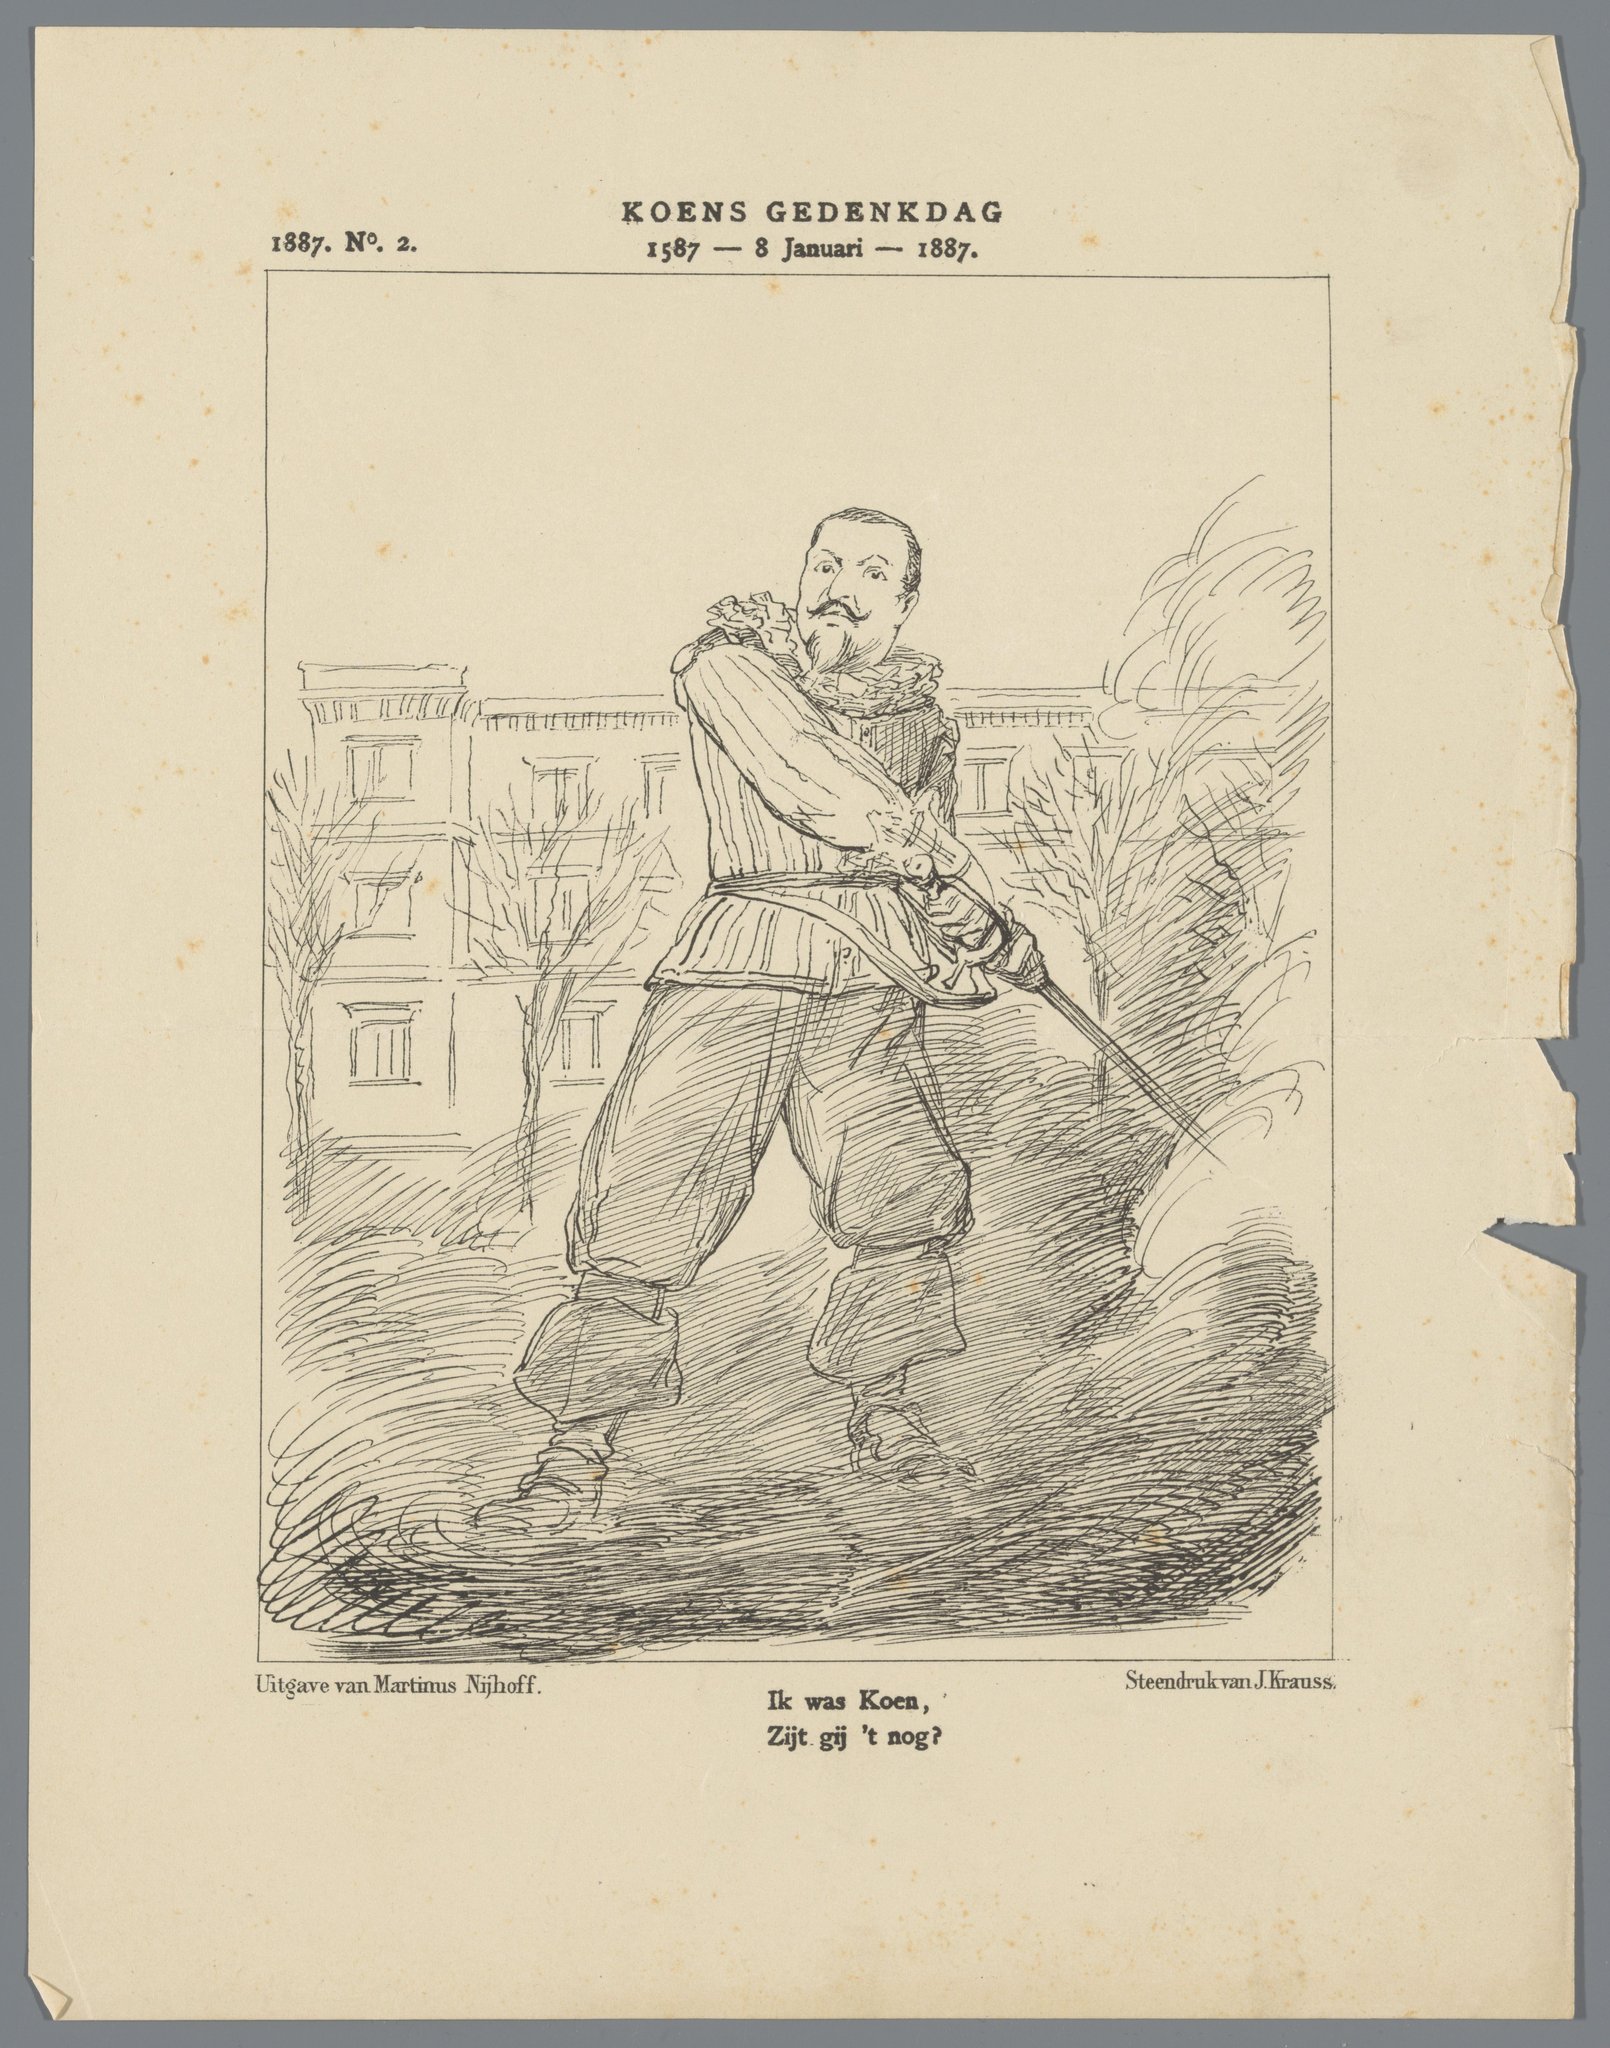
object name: print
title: Koens gedenkdag 1587 - 8 Januari - 1887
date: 1887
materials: paper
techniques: lithograph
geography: netherlands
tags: hoorn (north holland)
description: Spotprent bij de 300ste gedenkdag van Jan Pietersz. Coen, 1587-1887. Plaat verschenen bij het weekblad De Nederlandsche Spectator, nr. 2, 1887.